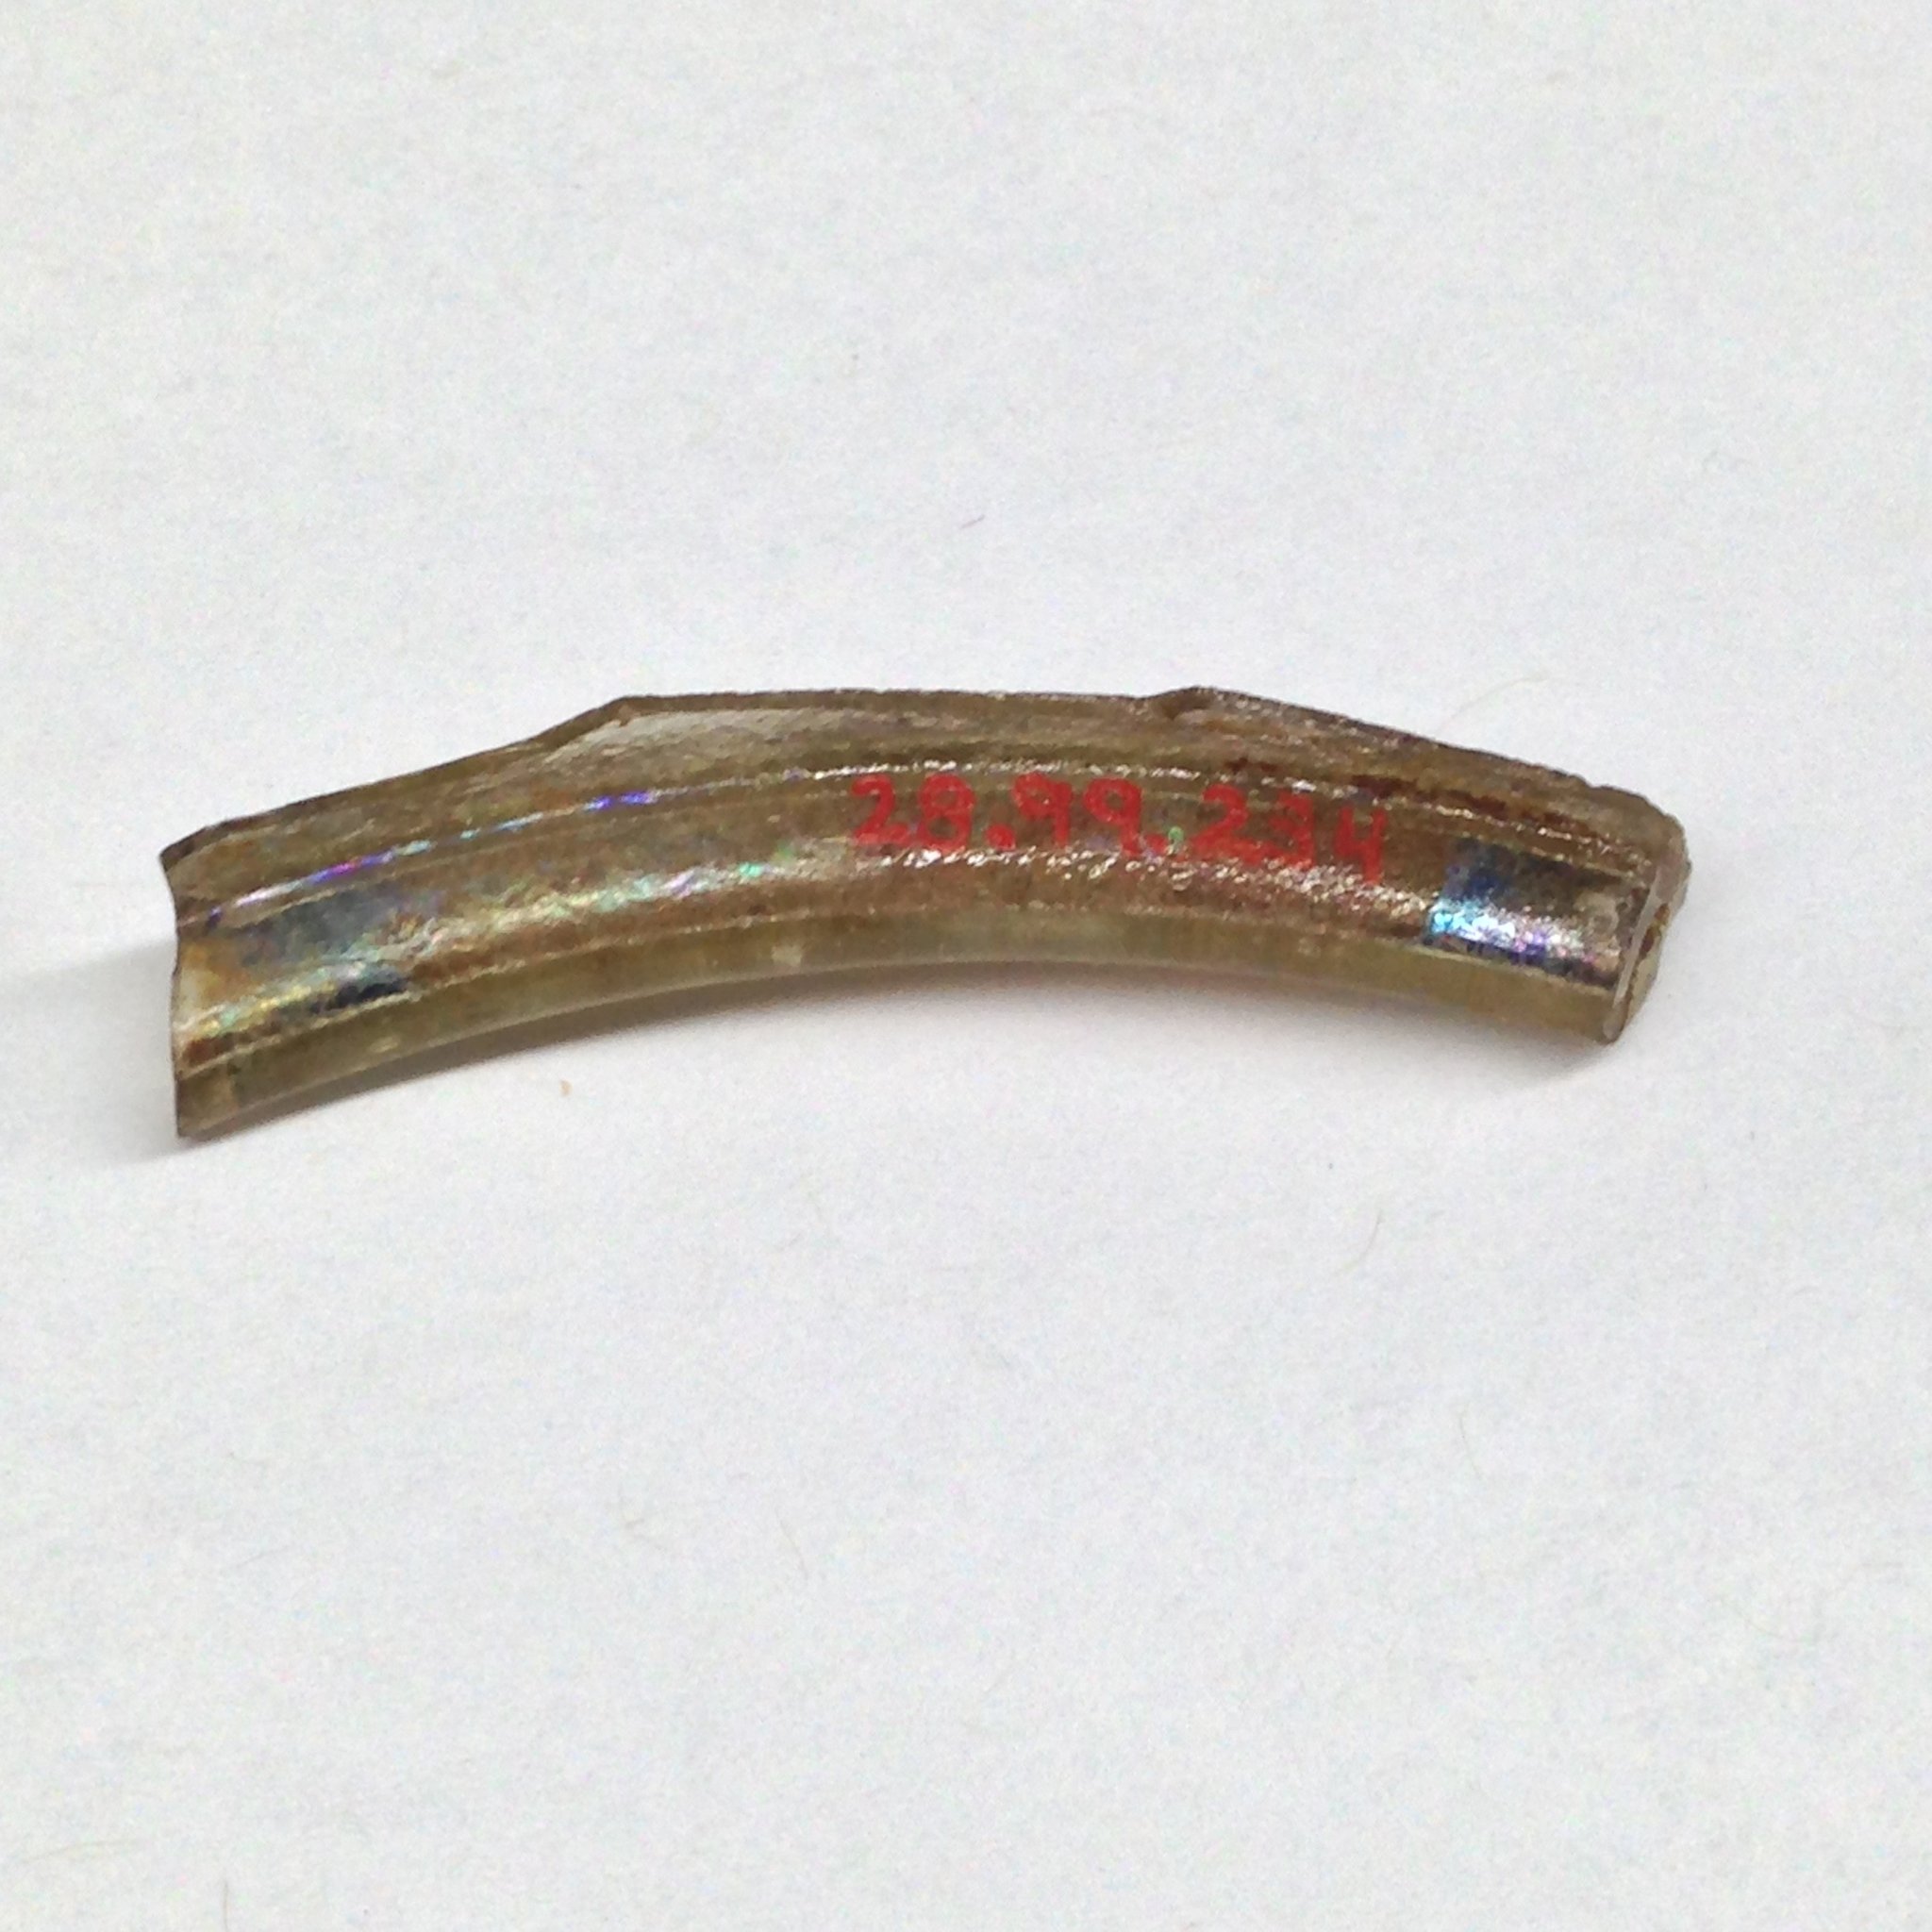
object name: fragment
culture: european or middle eastern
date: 1150-1250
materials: ceramic, glass